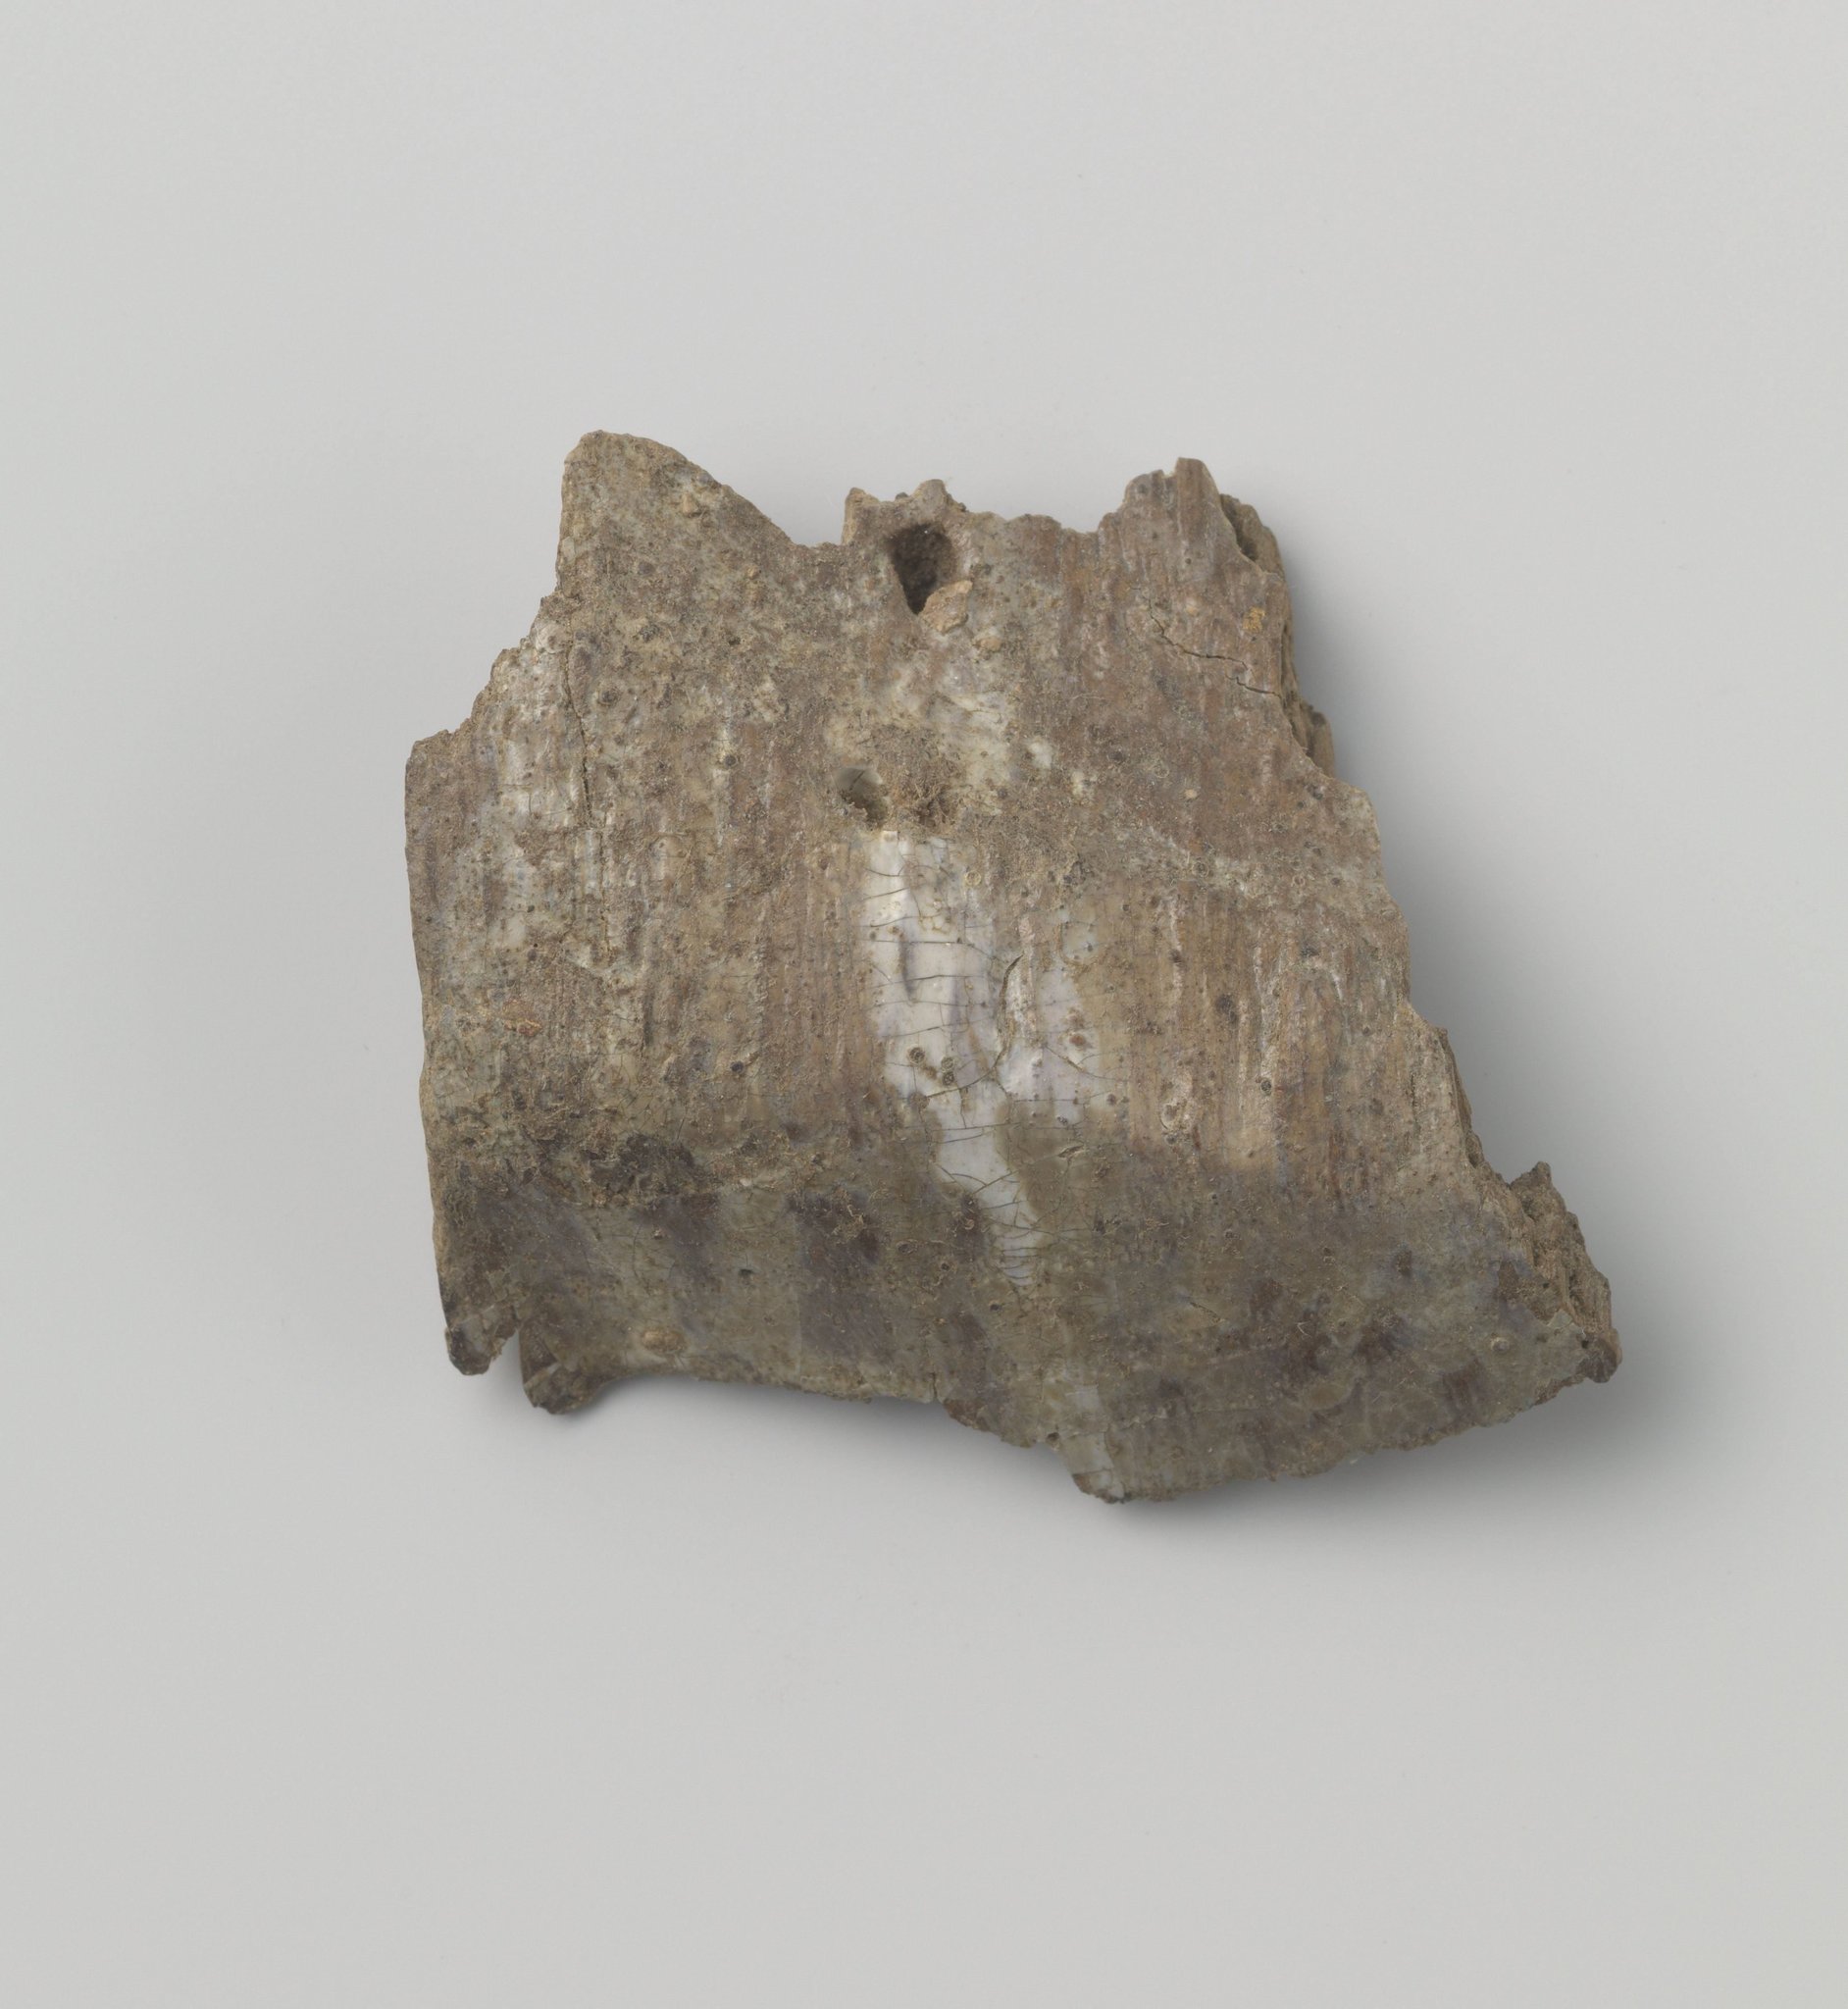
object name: sculpture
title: Fragment; (mogelijk) behorend tot het retabel van Soest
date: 1475-1499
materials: wood